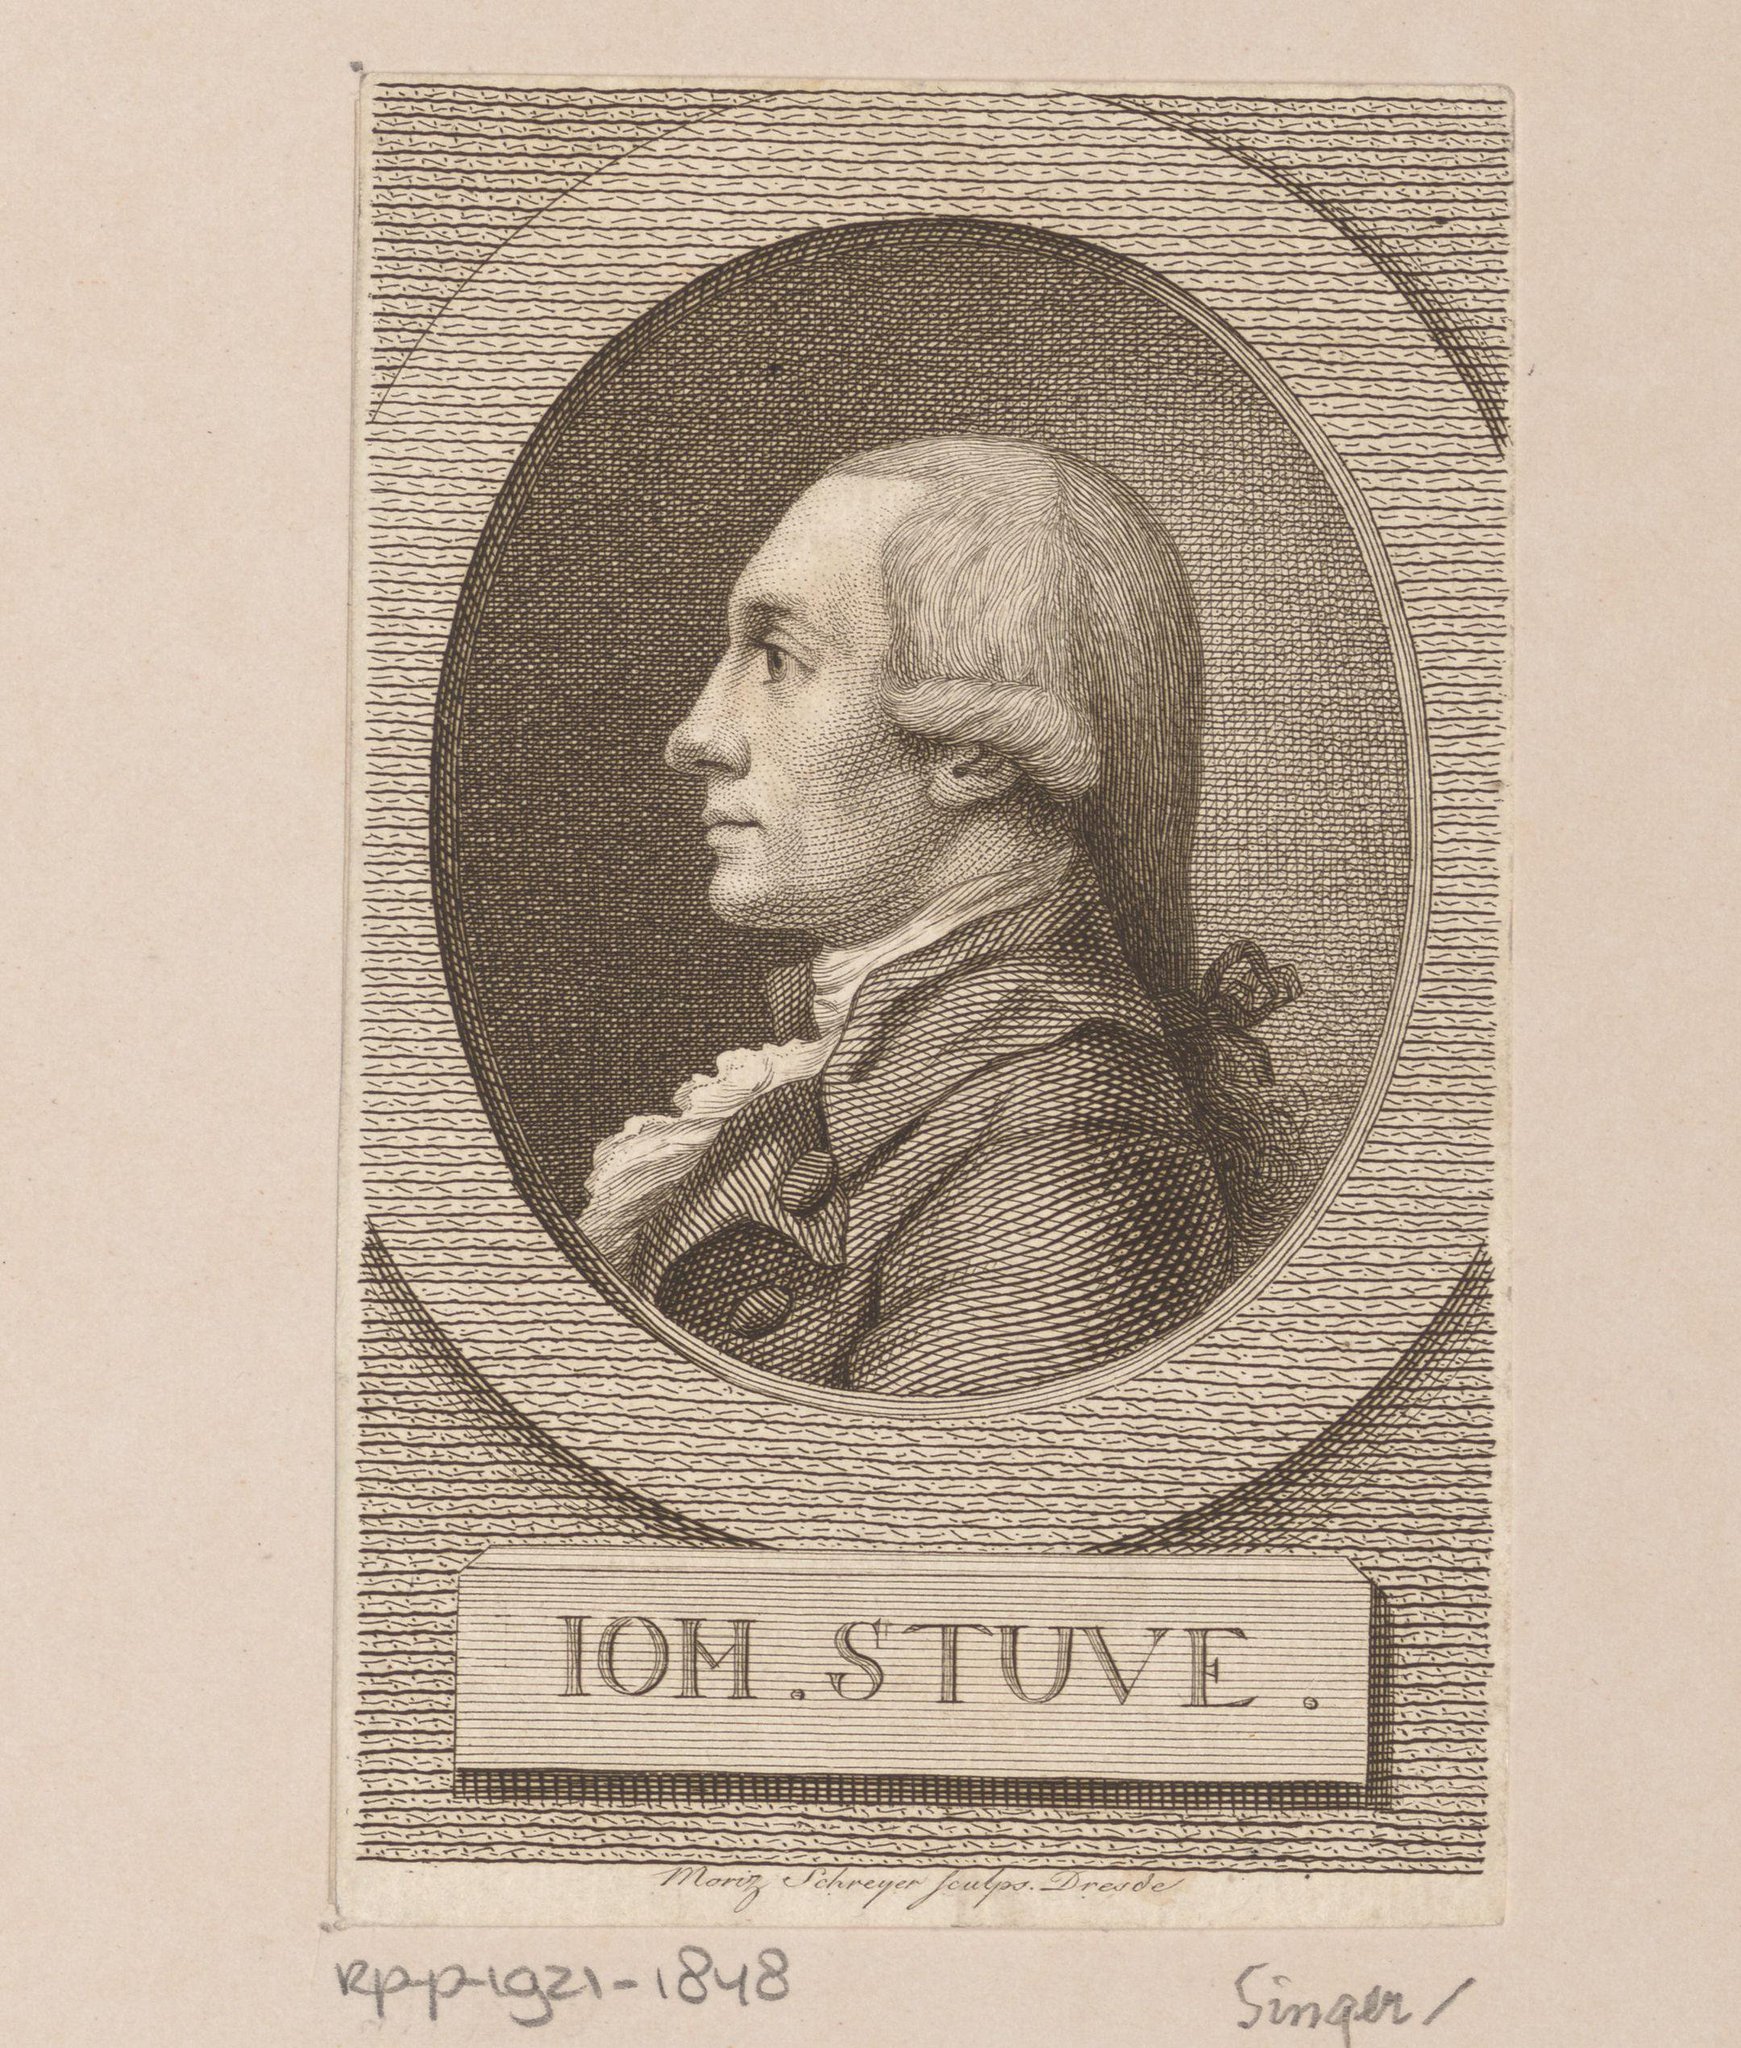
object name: print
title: Portret van Johann Stuve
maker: johann friedrich moritz schreyer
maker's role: print maker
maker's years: 1768-1795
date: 1794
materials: paper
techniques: engraving, etching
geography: dresden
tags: historical persons, portrait of a writer, professor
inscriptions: collector's mark: Lugt 2233